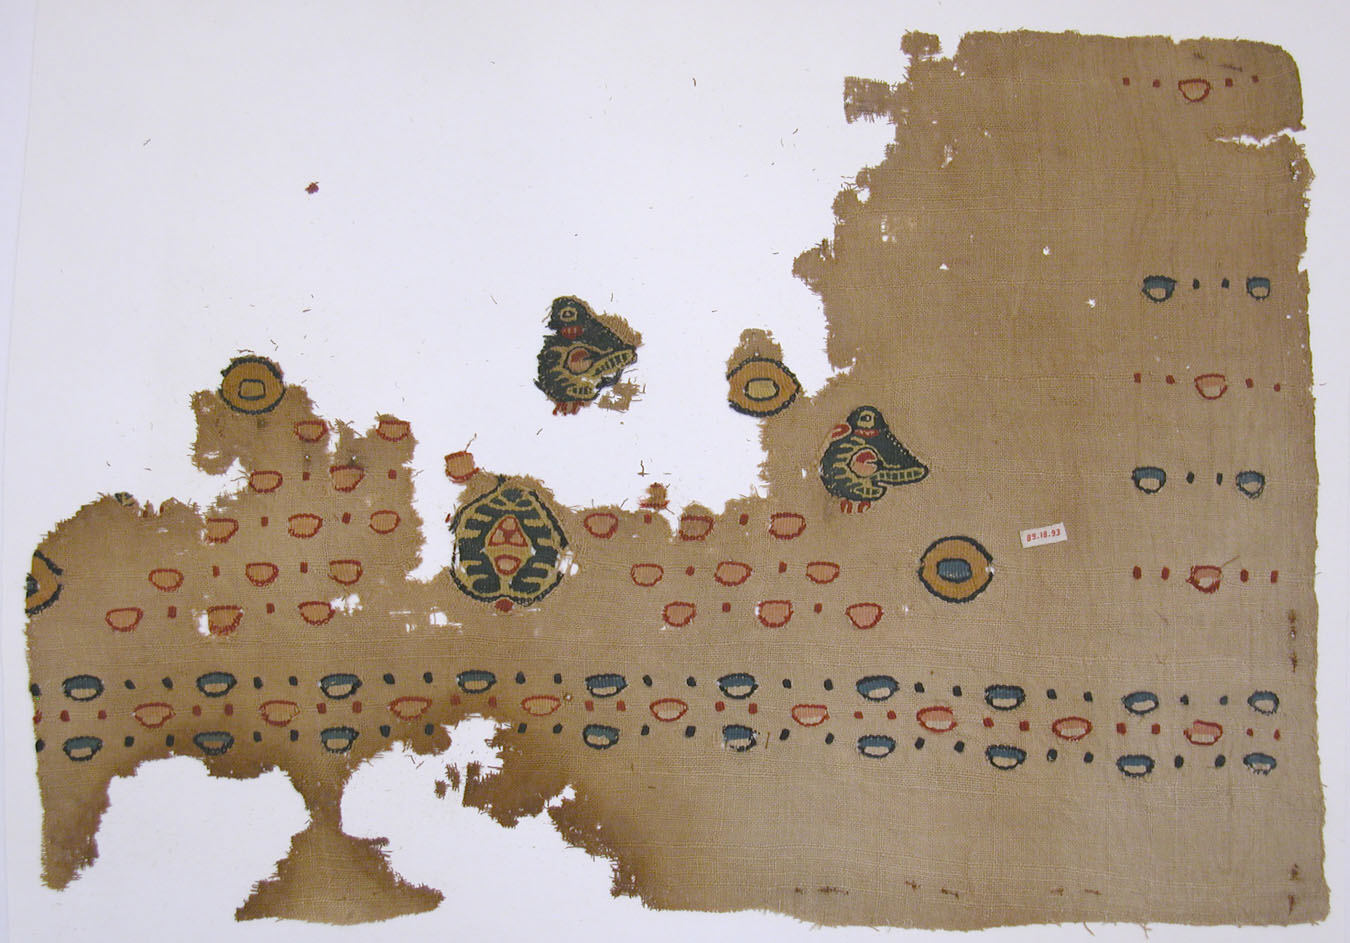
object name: textile fragment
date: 401-600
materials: linen, wool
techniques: weave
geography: egypt